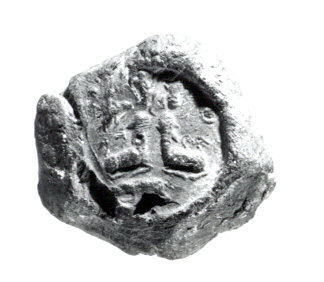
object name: sealing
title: Sealing with stamp seal impression: confronted sphinxes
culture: assyrian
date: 1800-1701 BCE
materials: ceramic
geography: anatolia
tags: sphinx